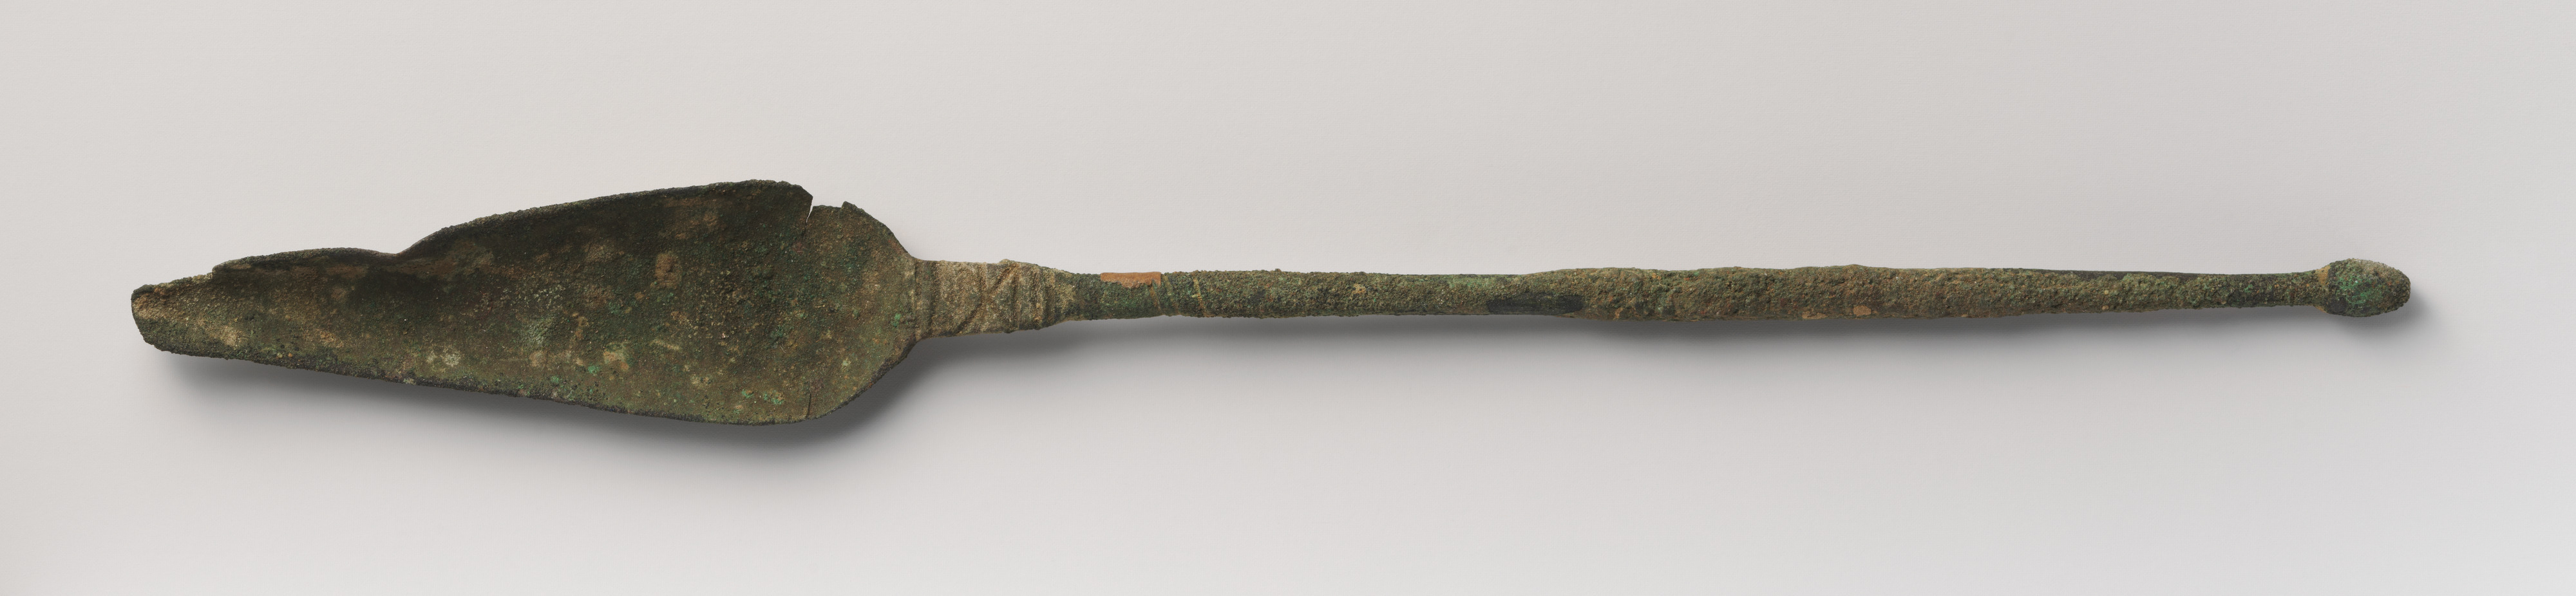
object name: ladle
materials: copper alloy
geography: egypt